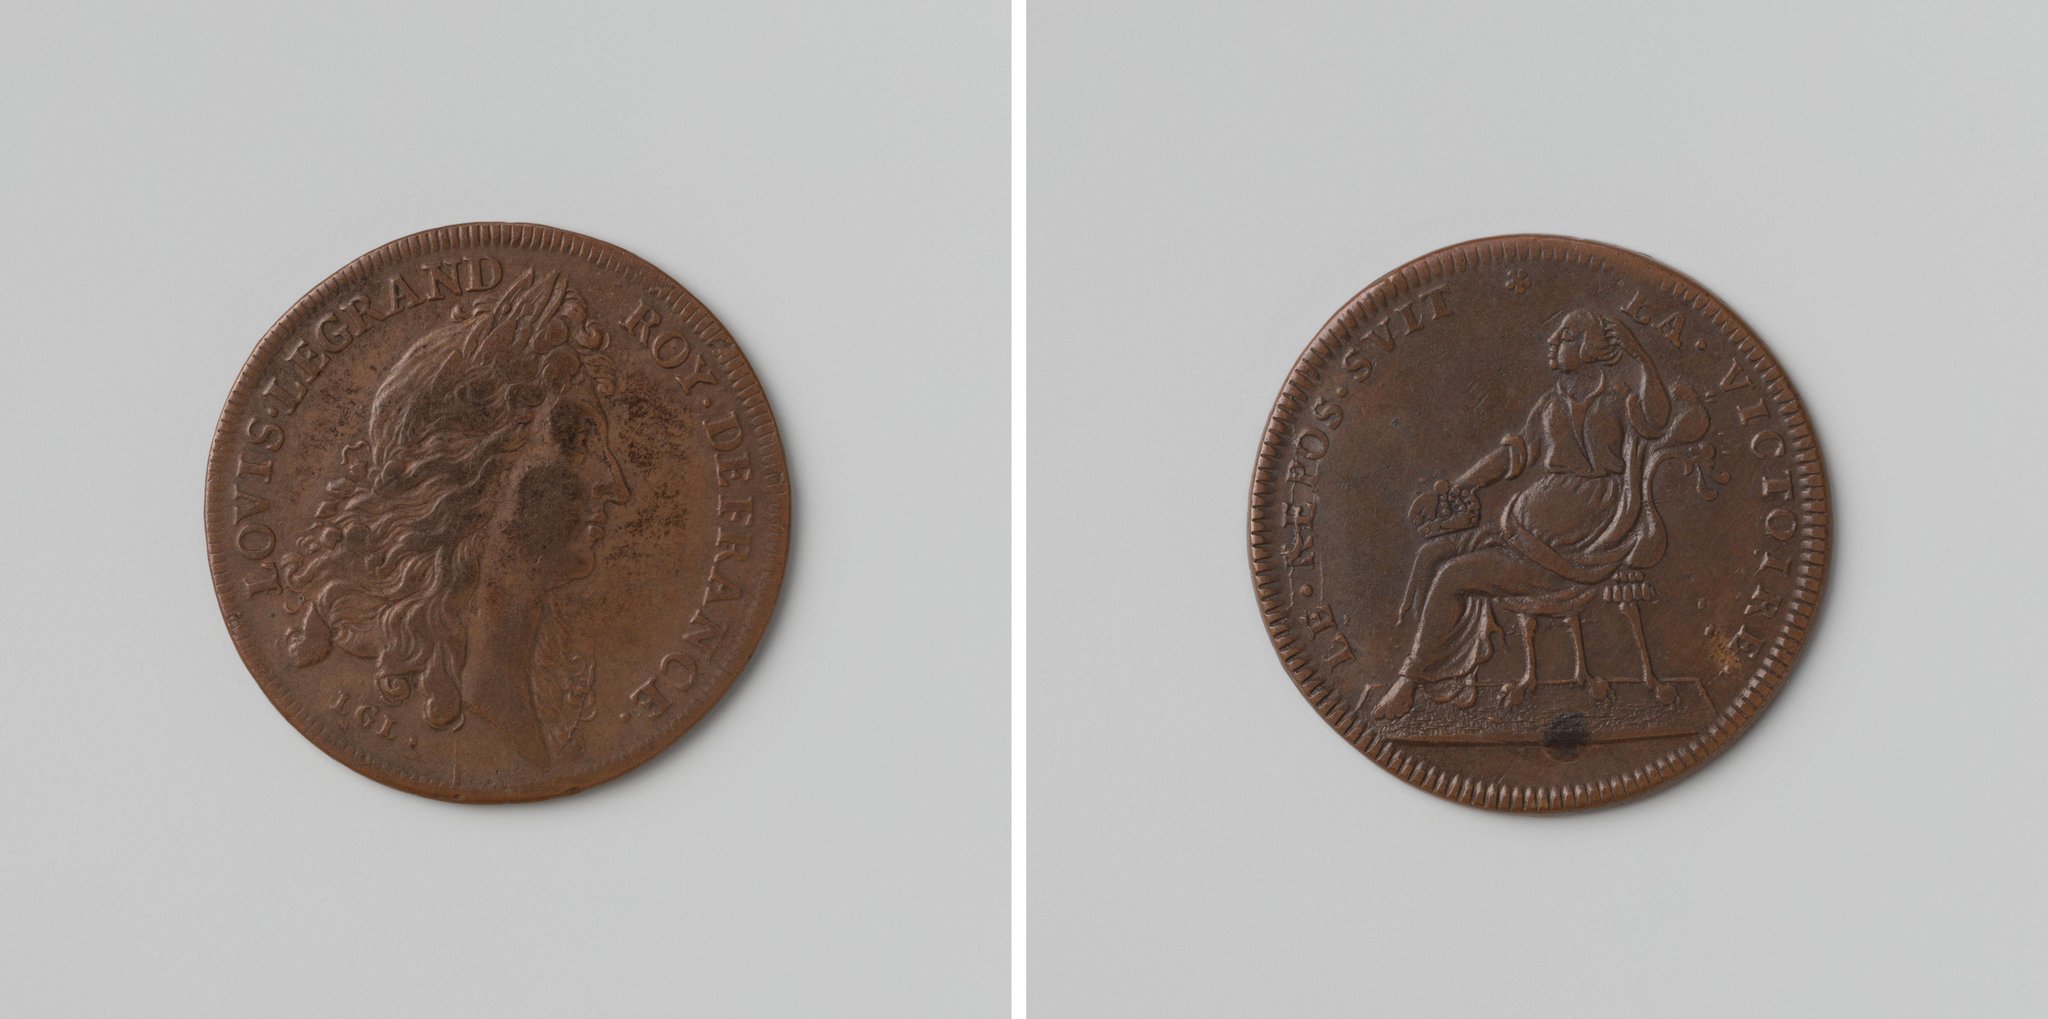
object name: jeton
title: Twintigjarige bestand van Regensburg tussen Frankrijk, de Keizer, Spanje en de Nederlanden, rekenpenning geslagen ter ere van Lodewijk XIV, koning van Frankrijk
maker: lazarus gottlieb lauffer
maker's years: 1660-1700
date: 1684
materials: copper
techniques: striking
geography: nuremberg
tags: lodewijk xiv (koning van frankrijk)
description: Koperen penning. Voorzijde: borststuk man met lauwerkrans binnen omschrift. Keerzijde: zittende vrouw, voorstellende de Rust, houdt kroon op haar knie binnen omschrift